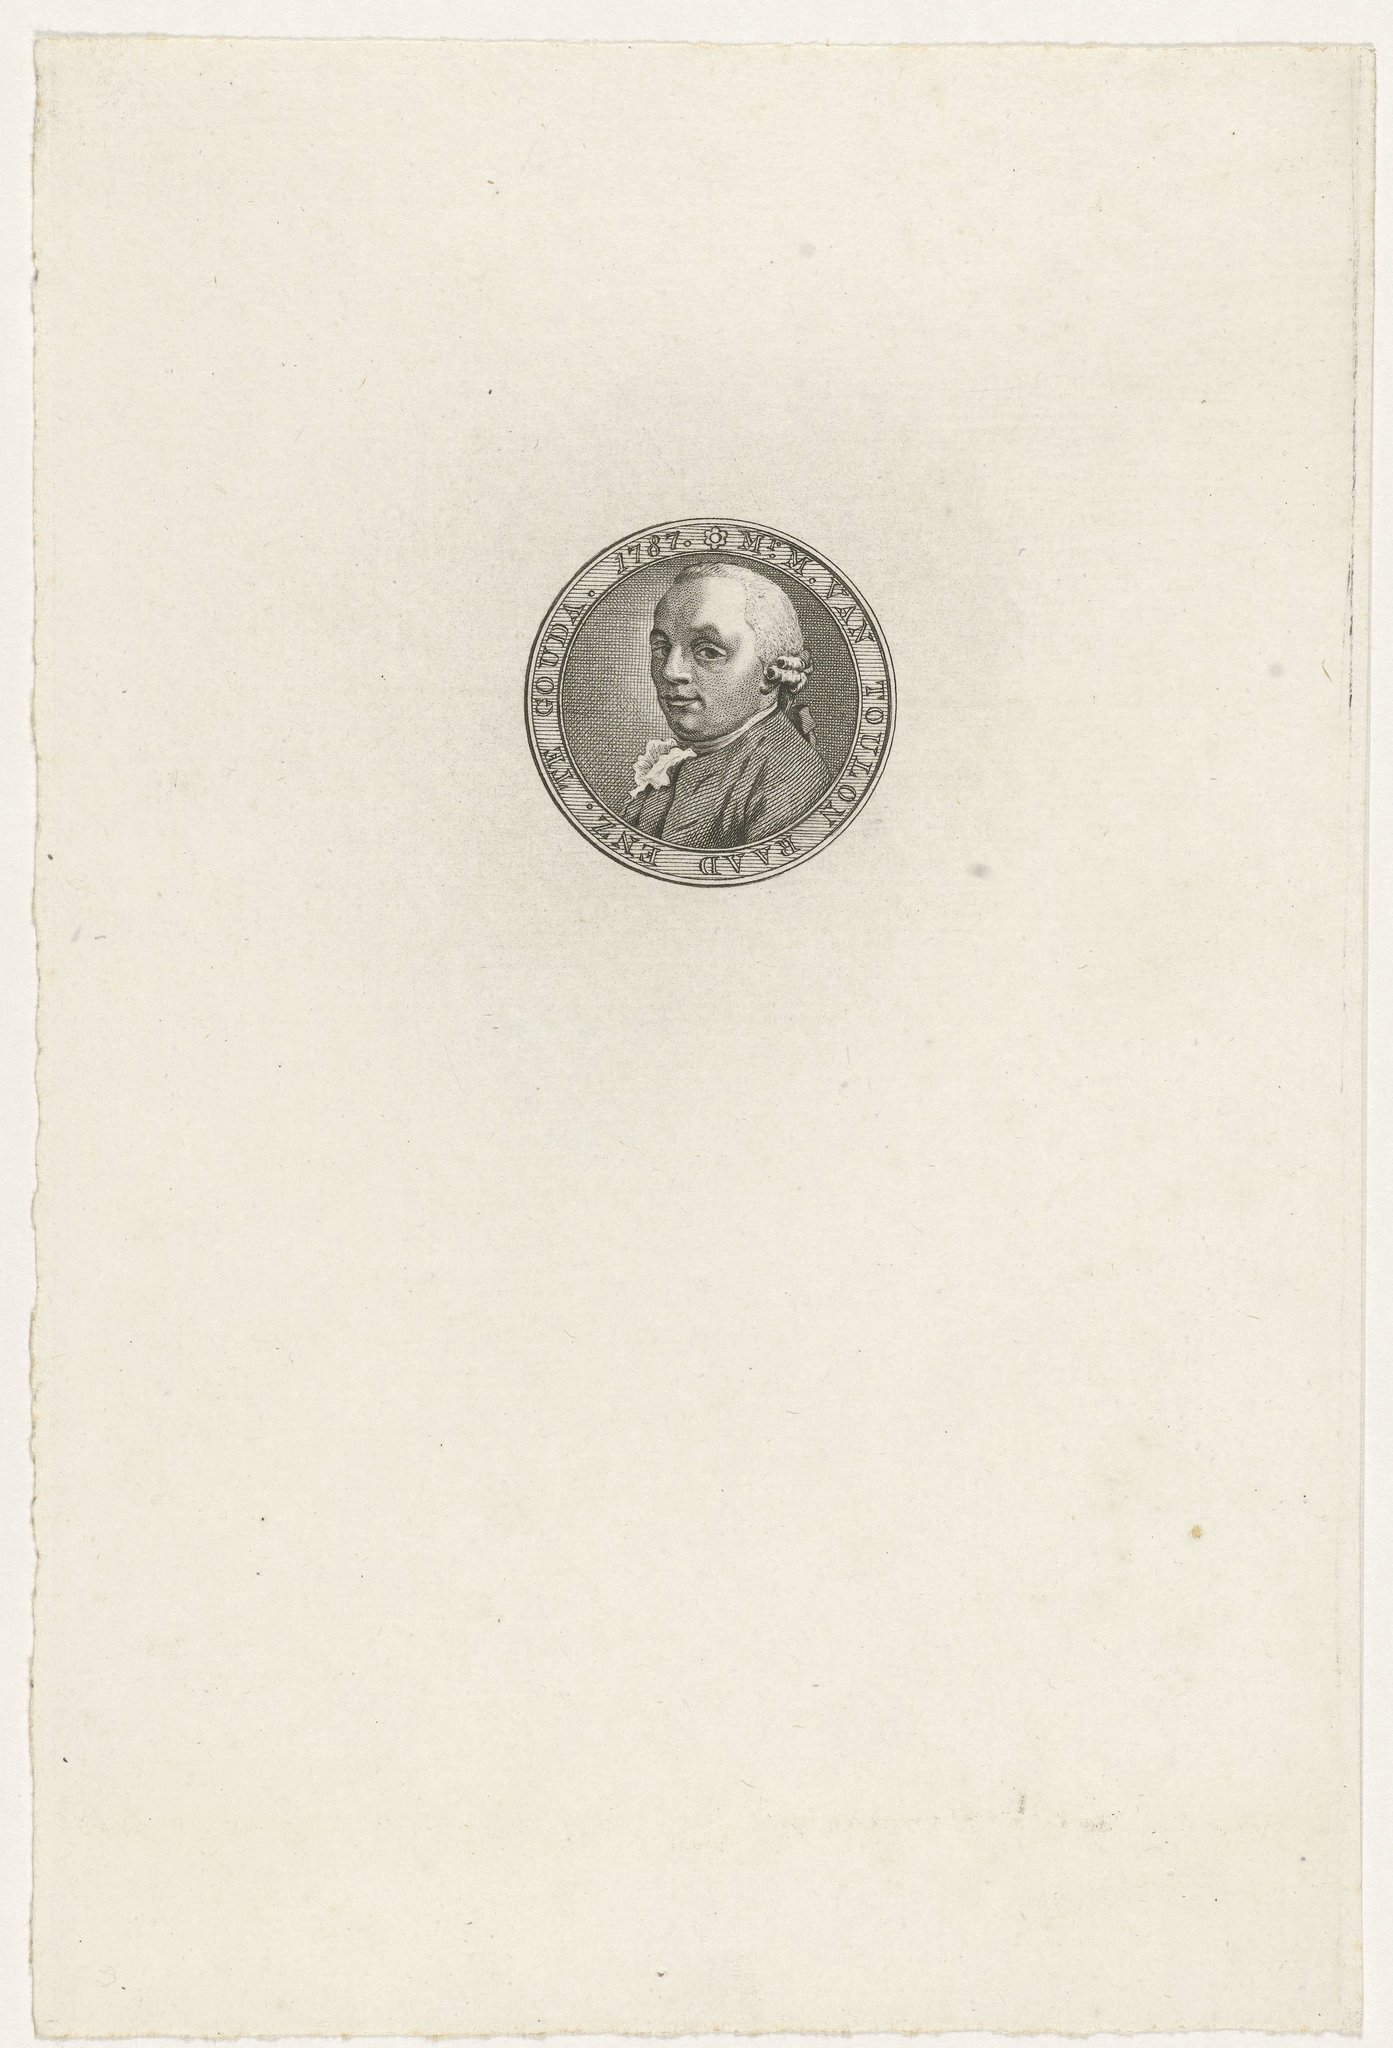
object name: print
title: Portretten van patriotten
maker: abraham jacobsz. hulk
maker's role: print maker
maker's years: 1751-1817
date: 1787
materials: paper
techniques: engraving, etching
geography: paris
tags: gouda, mayor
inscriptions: collector's mark: Lugt 2228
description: Buste van Martinus van Toulon naar links in een medaillon met randschrift in het Nederlands.